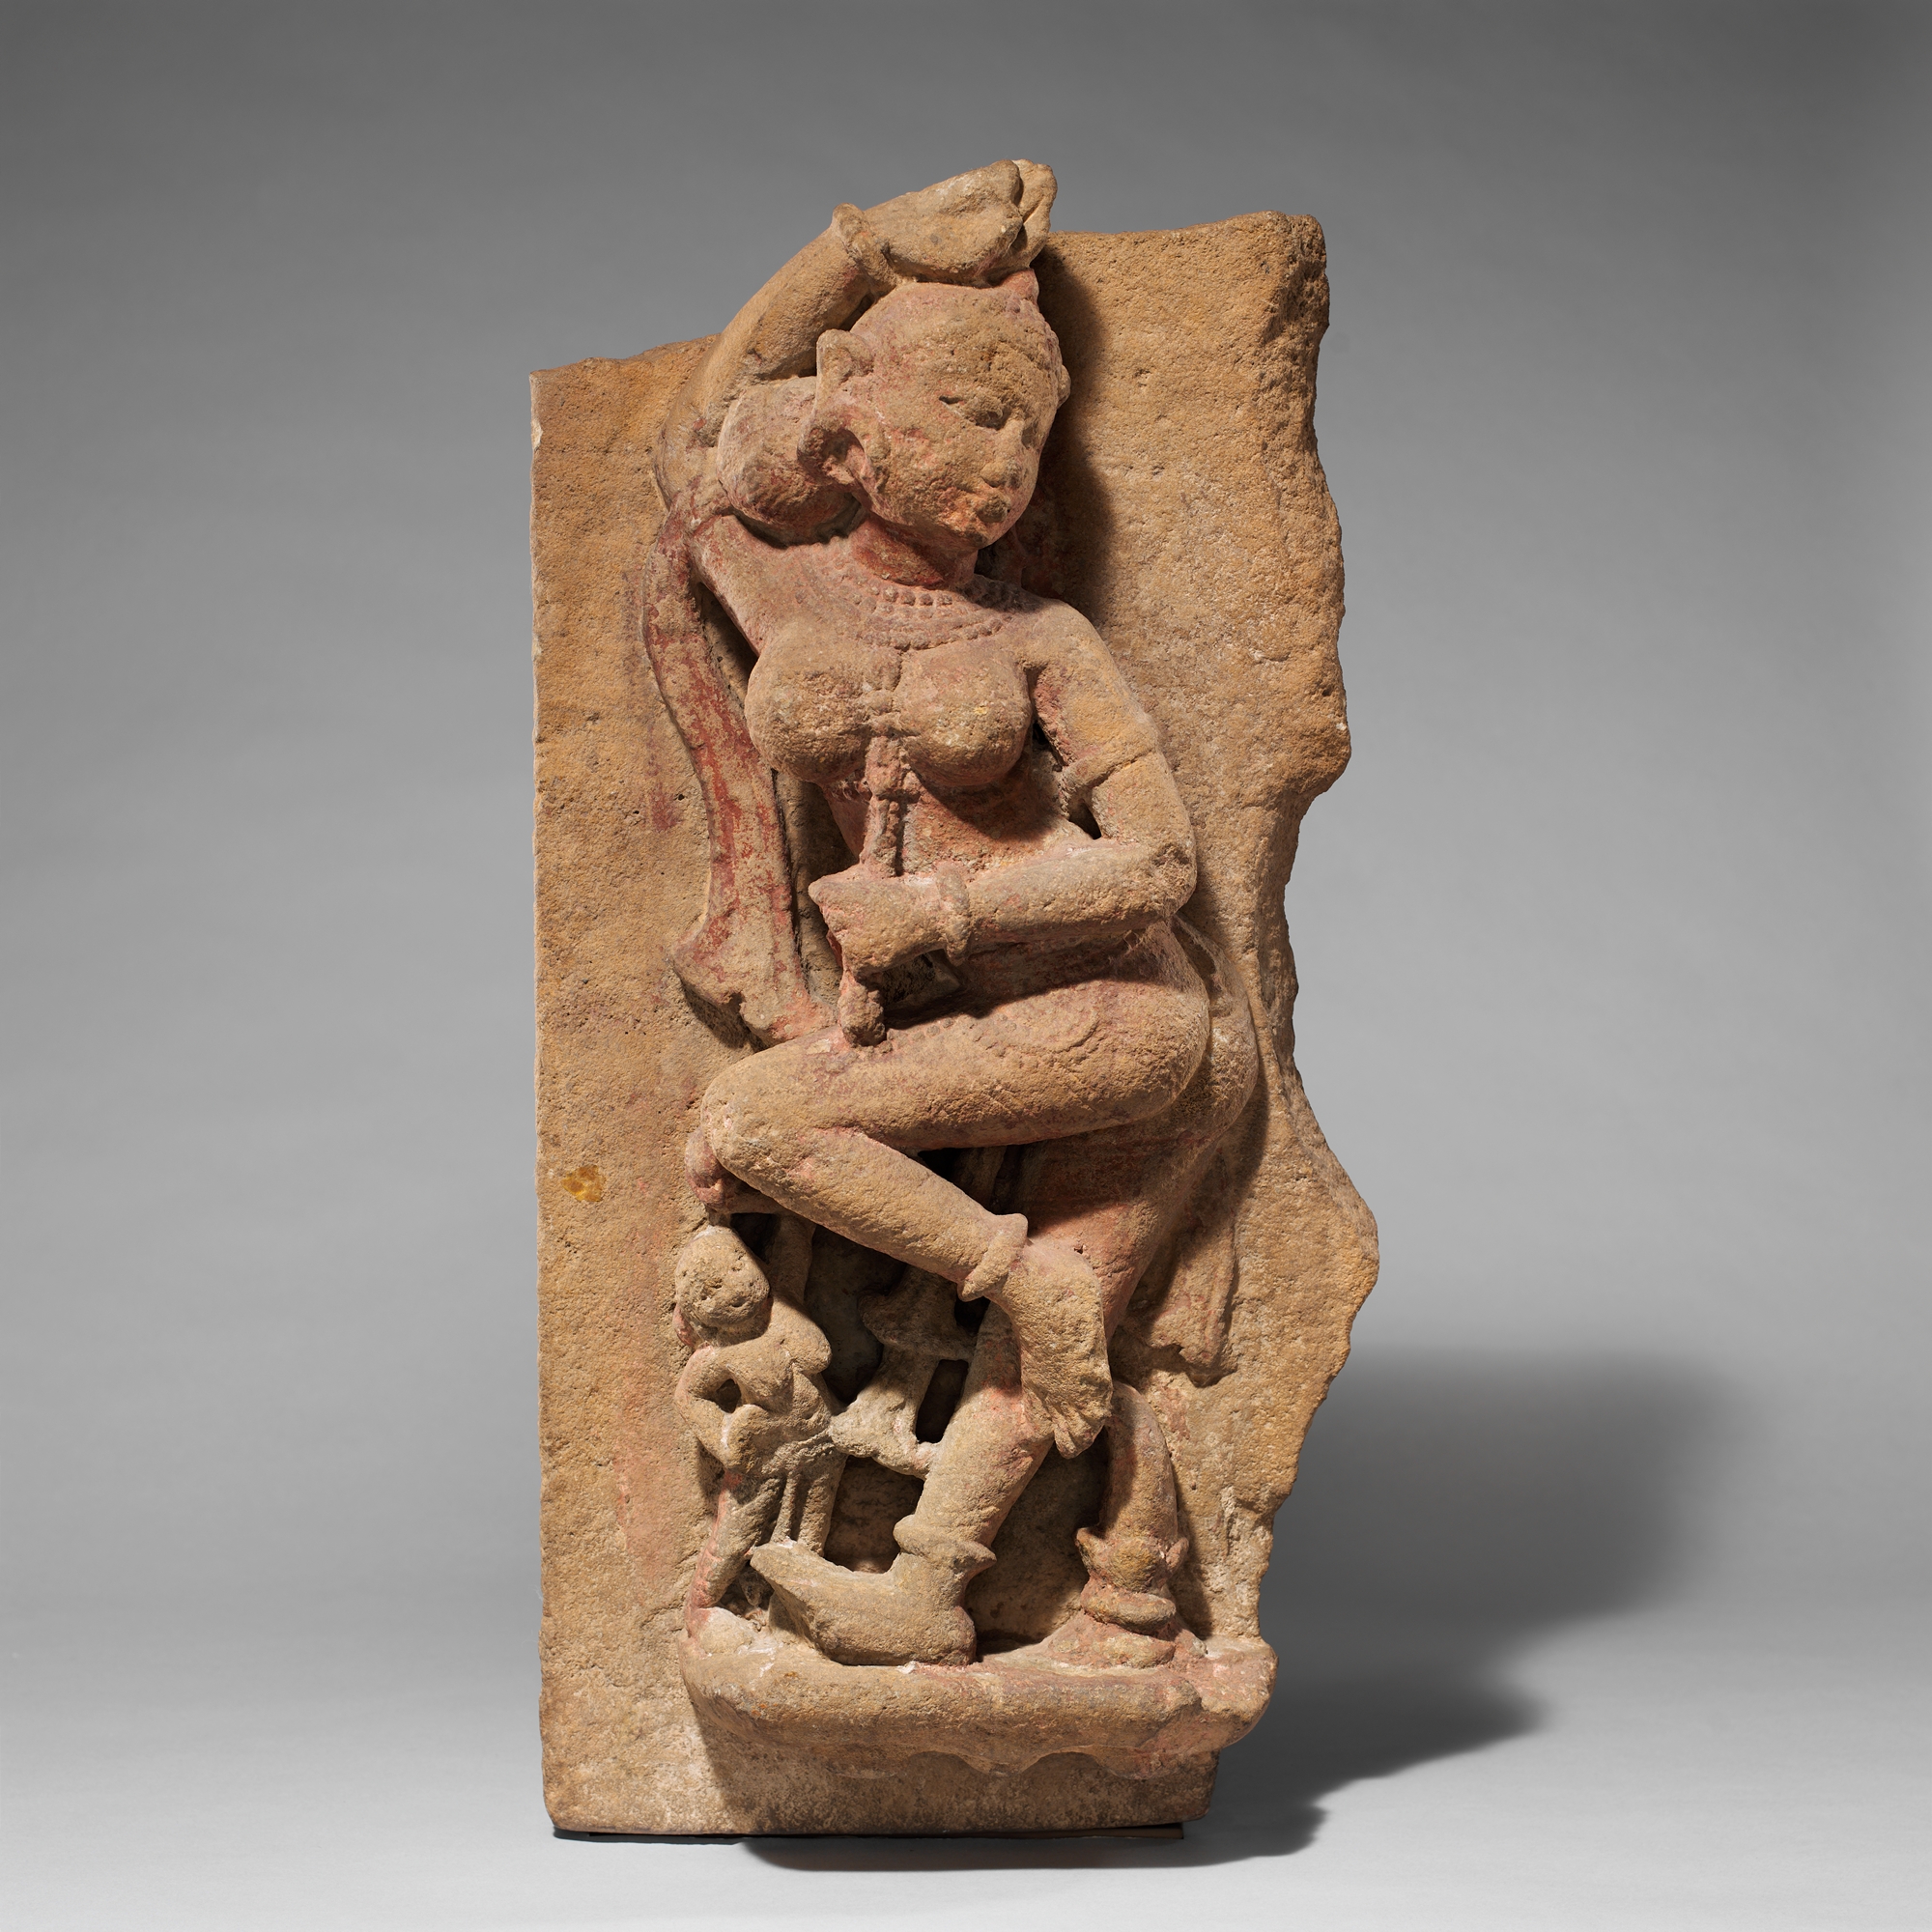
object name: figure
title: Dancing Apsaras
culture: indian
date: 1201-1400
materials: stone